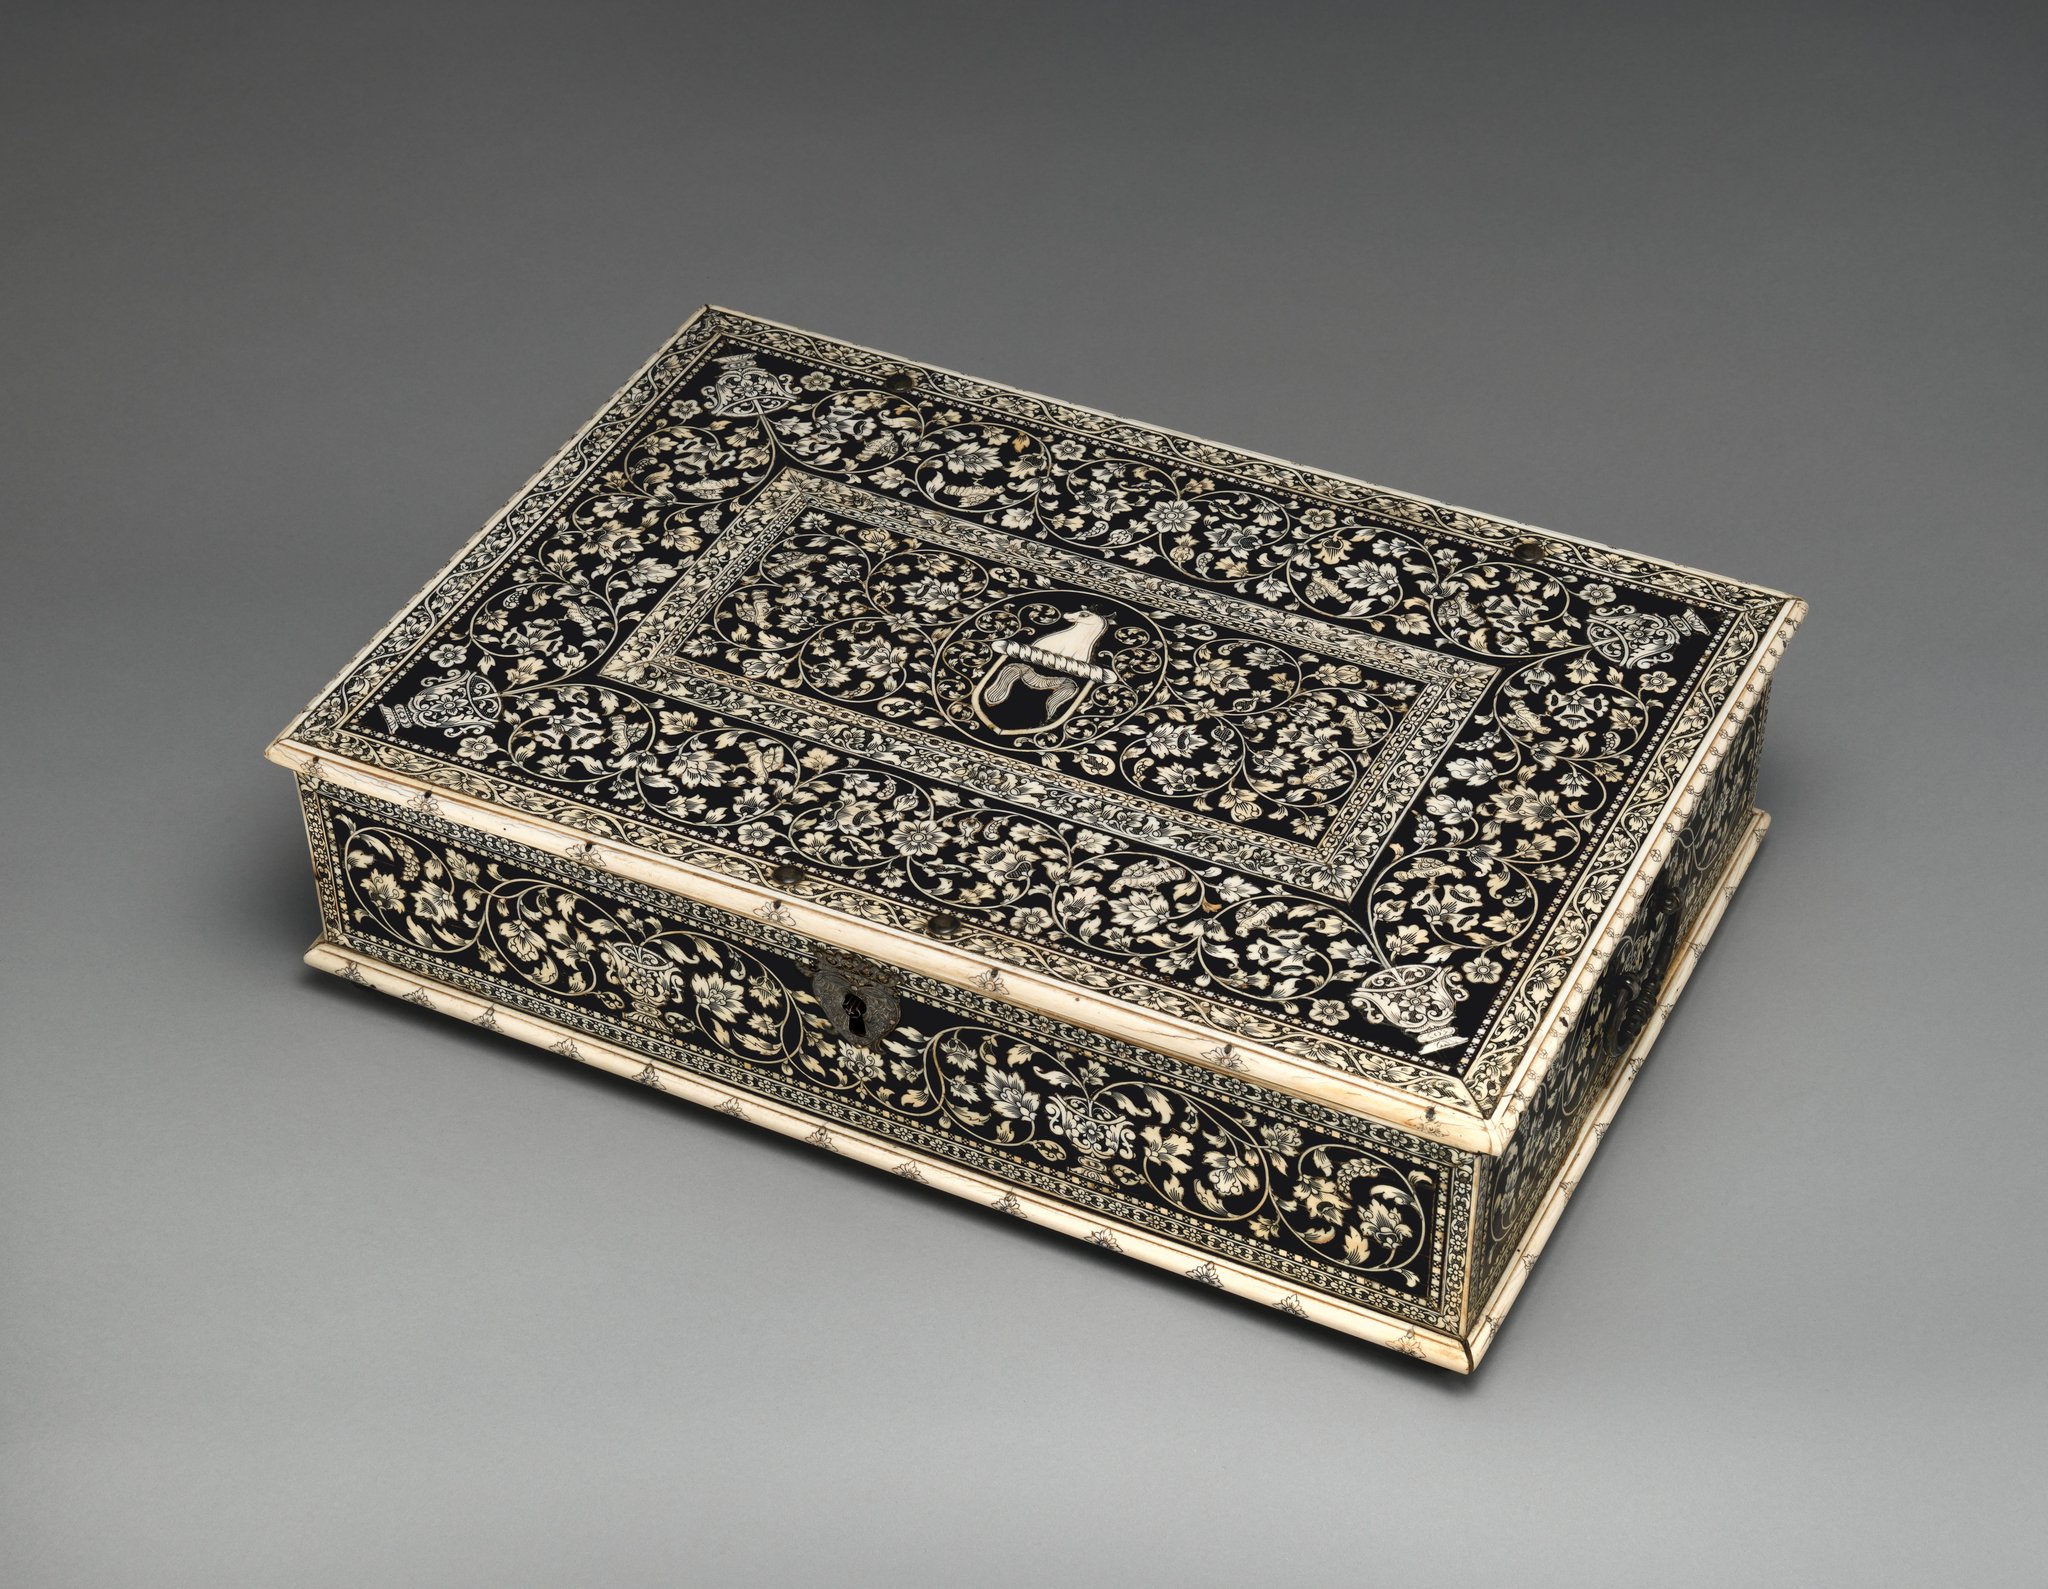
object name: casket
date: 1760-1765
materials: brass, wood, glass, iron, ivory, silver, shell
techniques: engraving